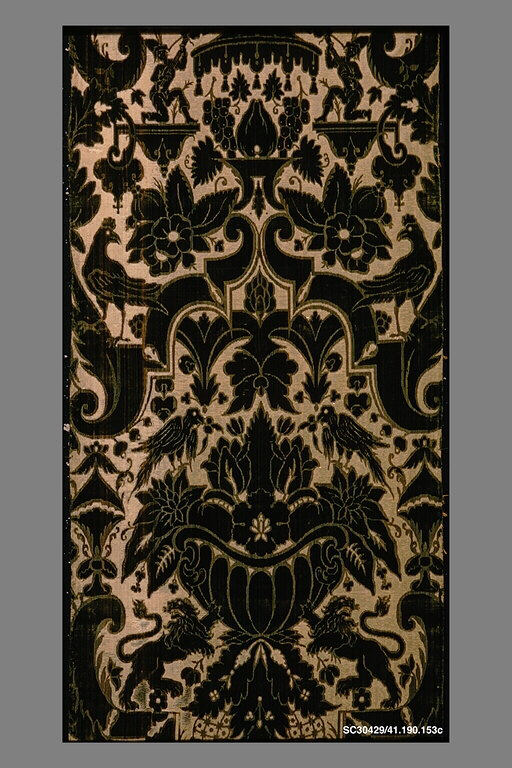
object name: length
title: Lengths of velvet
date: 1701-1733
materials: metal thread, silk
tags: birds,flowers